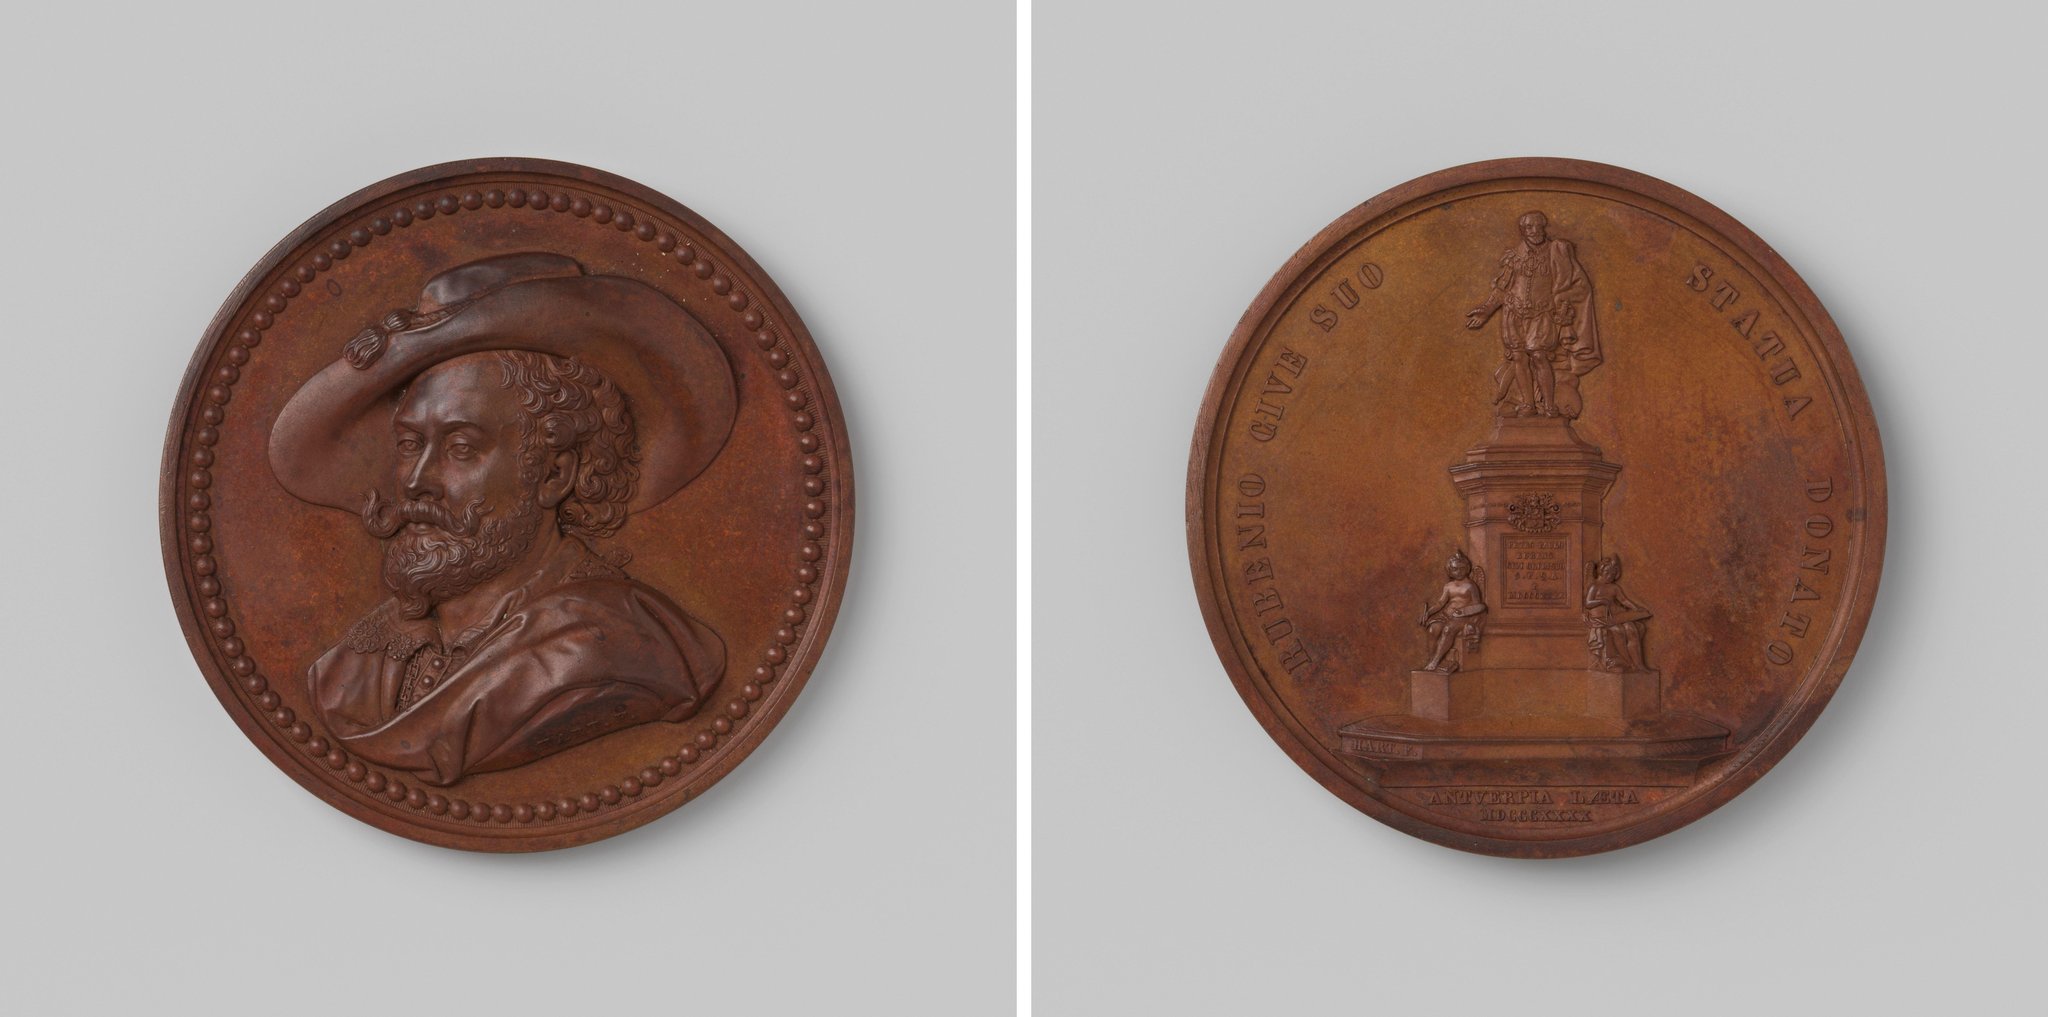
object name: history medal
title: Oprichting van een standbeeld voor de schilder Pieter Paul Rubens te Antwerpen, penning geslagen op last van de stad Antwerpen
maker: laurent joseph hart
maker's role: die cutter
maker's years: 1810-1860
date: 1840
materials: bronze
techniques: striking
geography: brussels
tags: draughtsman, peter paul rubens, antwerp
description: Bronzen penning. Voorzijde: borststuk man met hoed binnen parelrand. Keerzijde: monument binnen omschrift; afsnede: opschrift